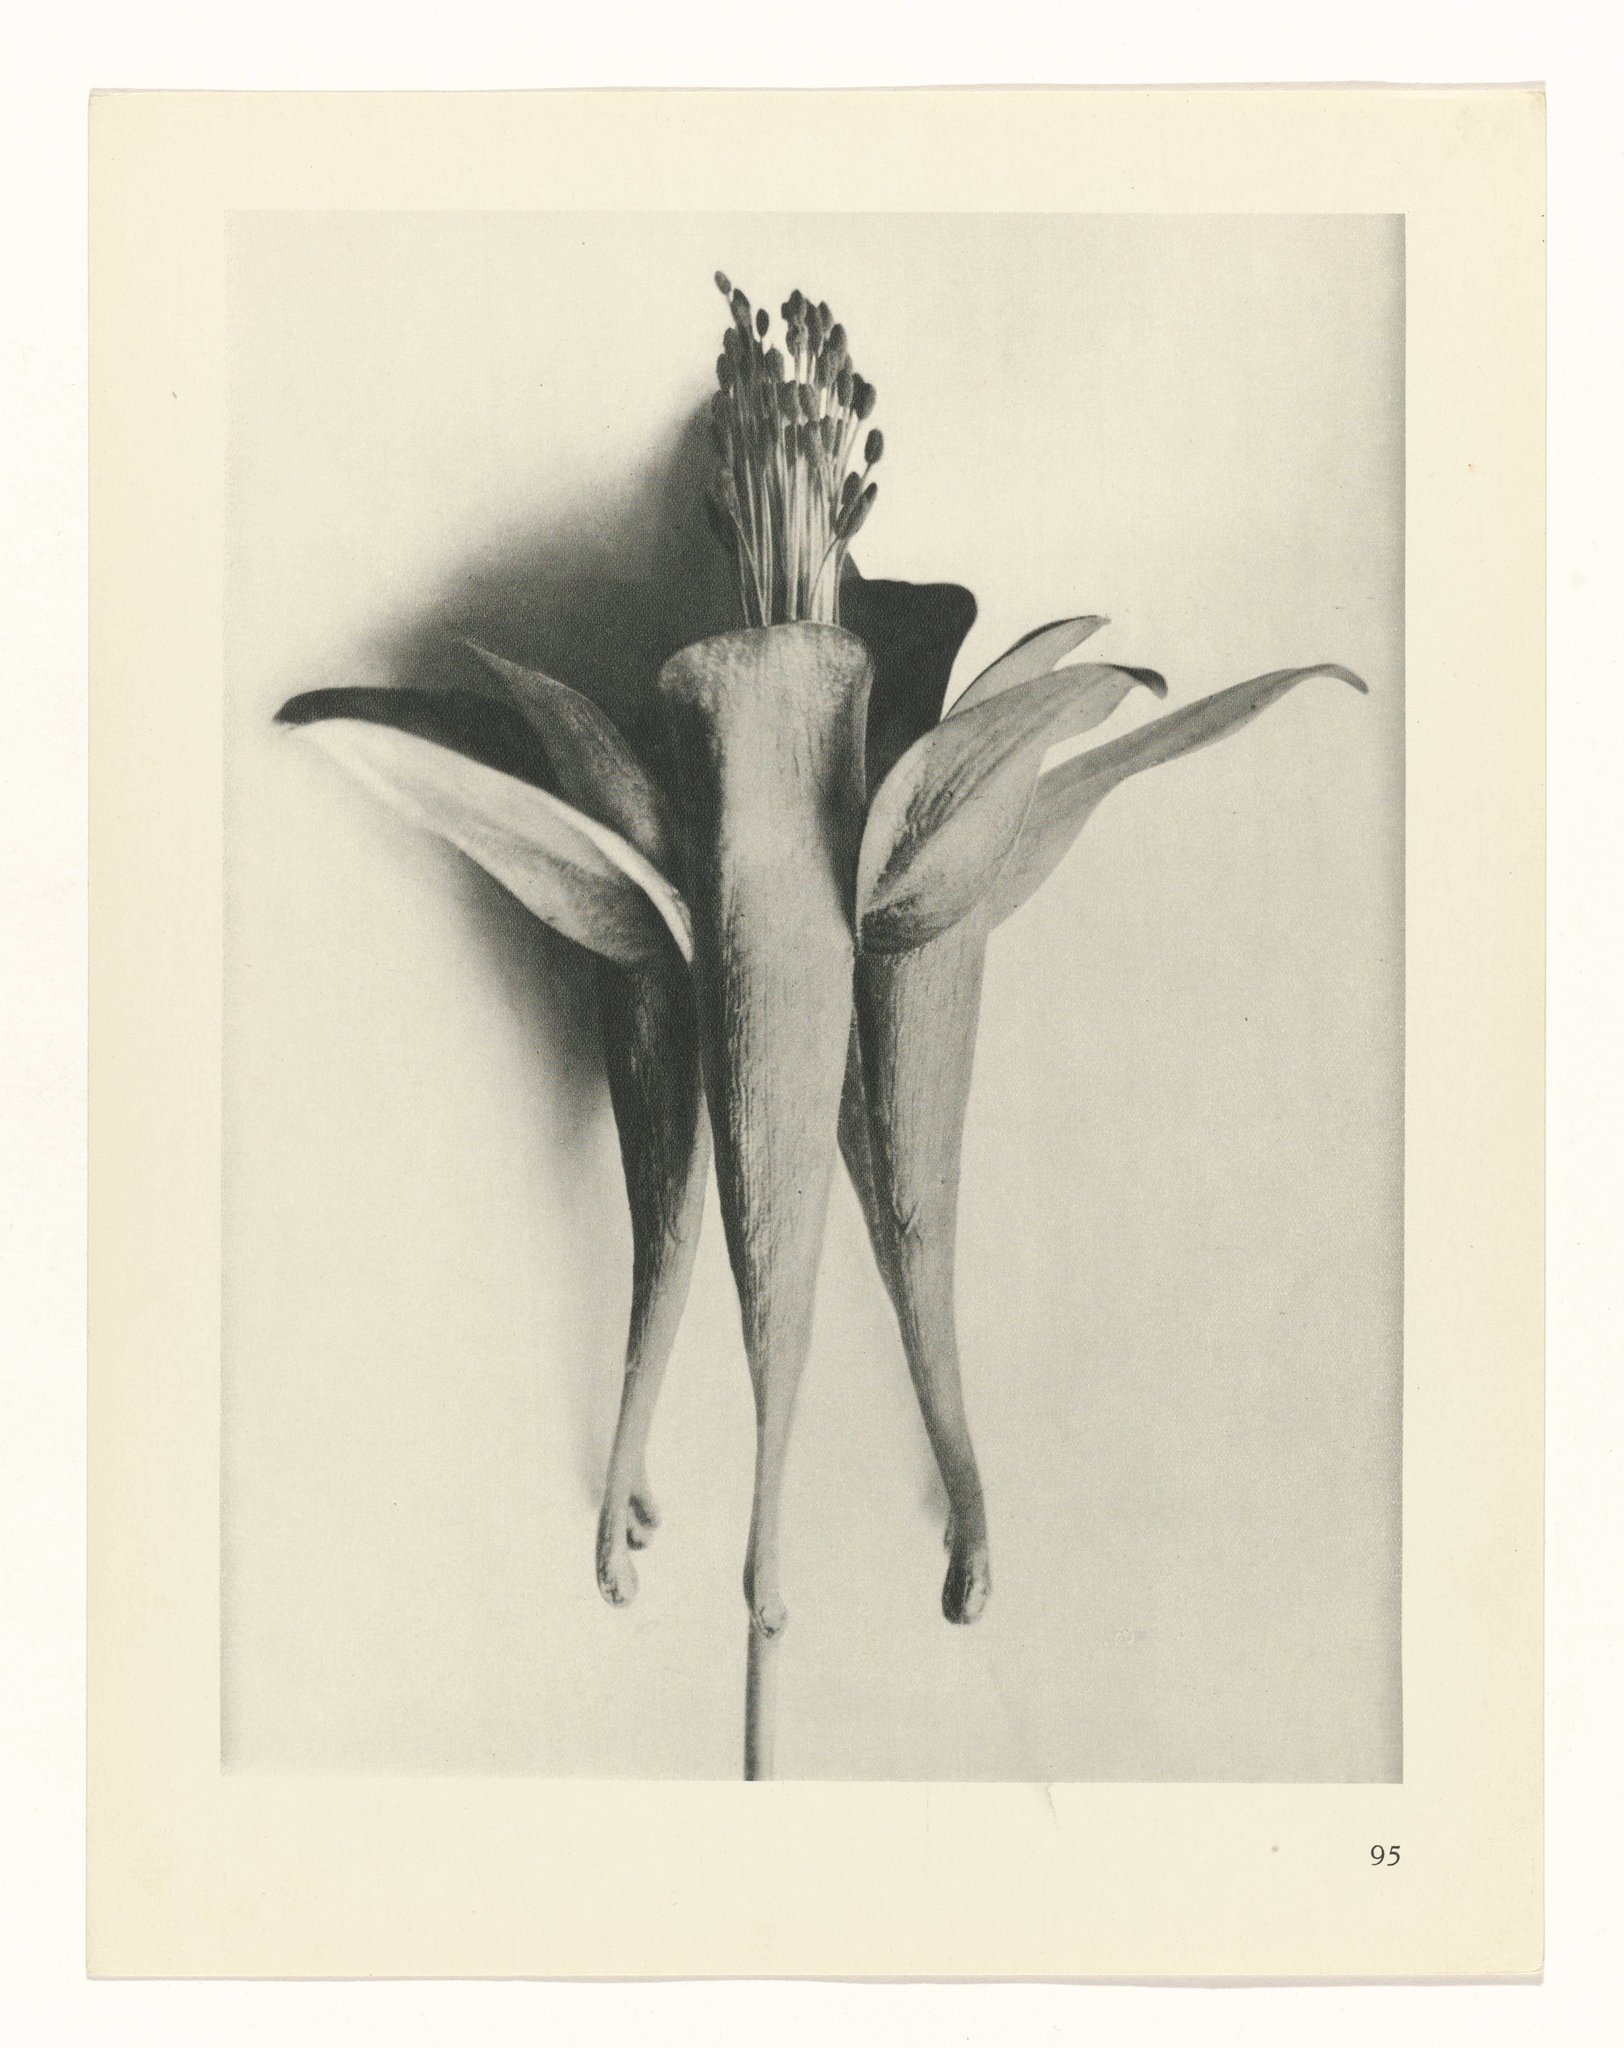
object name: photograph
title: Urformen der Kunst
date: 1928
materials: ink, paper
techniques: rotogravure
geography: berlin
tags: plants (in general)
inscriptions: number: ‘95’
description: facher Vergrößerung. Afkomstig uit losbladige uitgave.